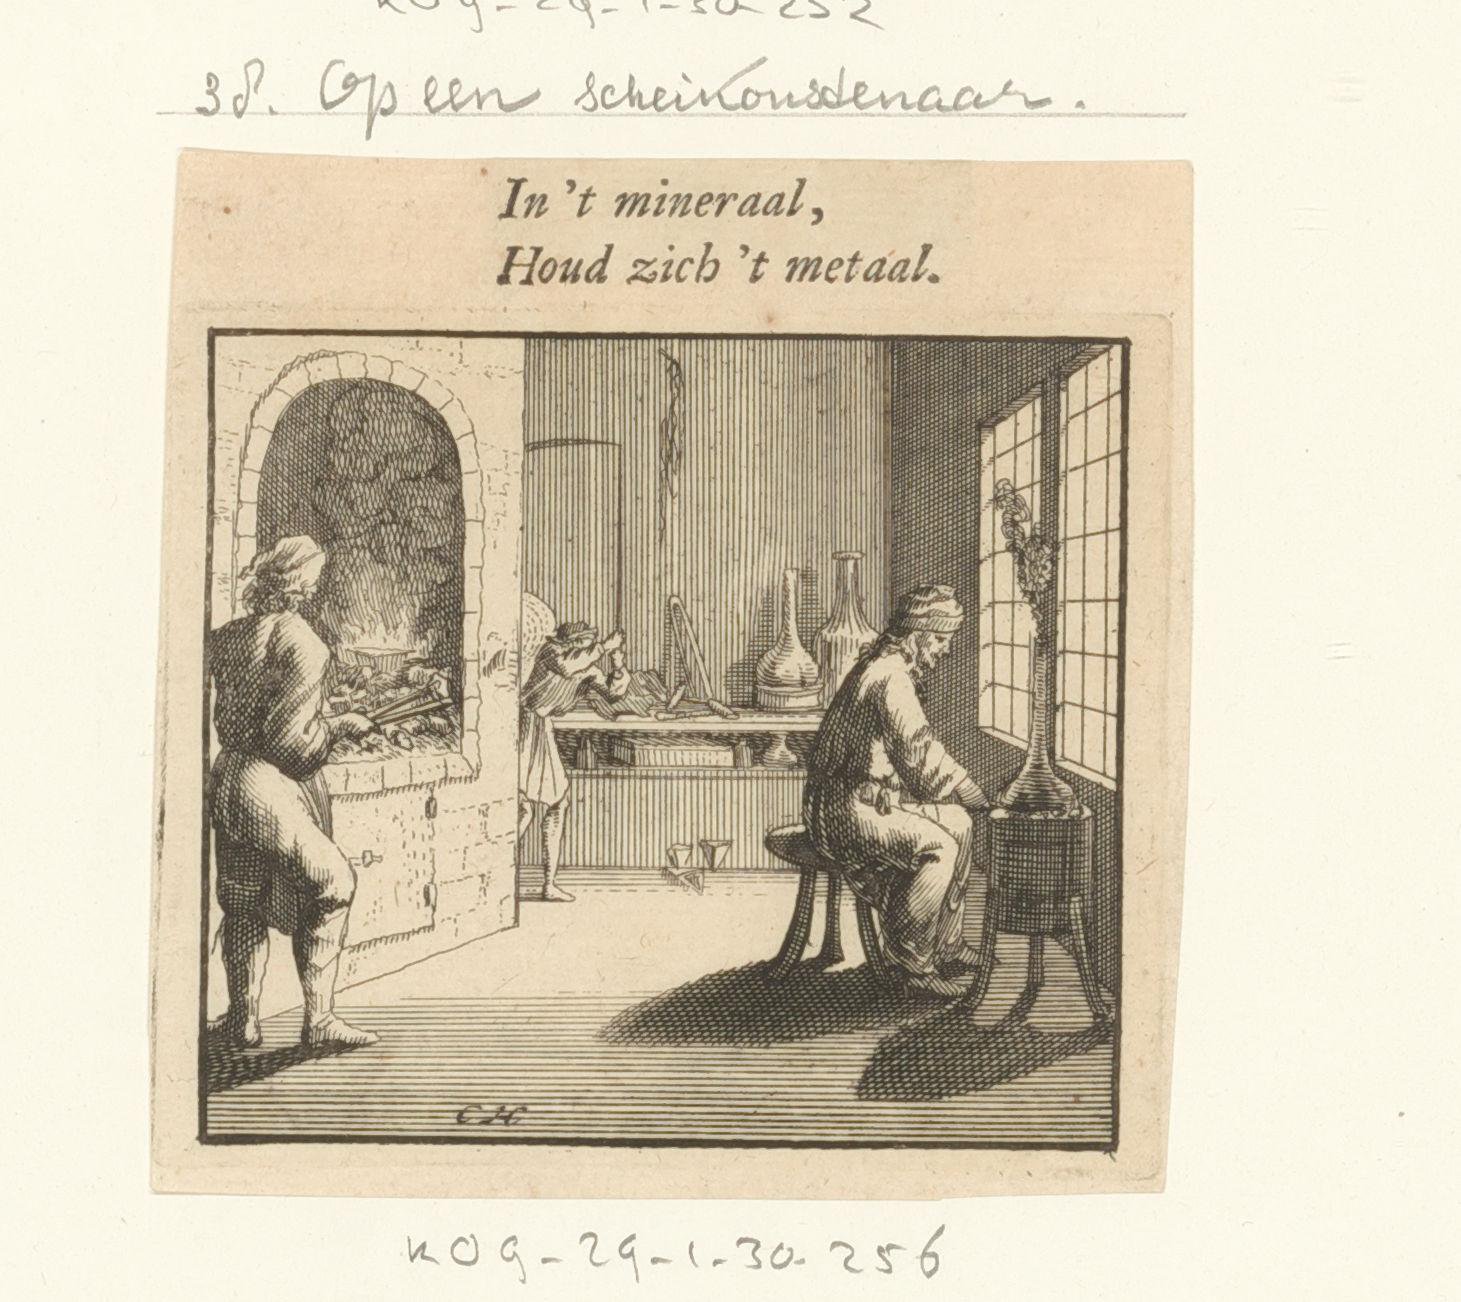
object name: print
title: In 't mineraal, Houd zich 't metaal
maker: cornelis huyberts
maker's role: print maker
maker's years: 1669-1709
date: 1725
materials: paper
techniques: etching, letterpress printing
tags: chemistry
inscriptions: stamp, collector's mark: Lugt 1641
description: Prent uit: Graauwhart, Hendrik. Voorbeeldelyke zeede-lessen, genoomen uyt den eersten toestand des werelds (...). Amsterdam: Johannes Ratelband, 1725. Prent ook gebruikt voor eerdere en (1709) latere uitgave (1756, 1761 en 1764).